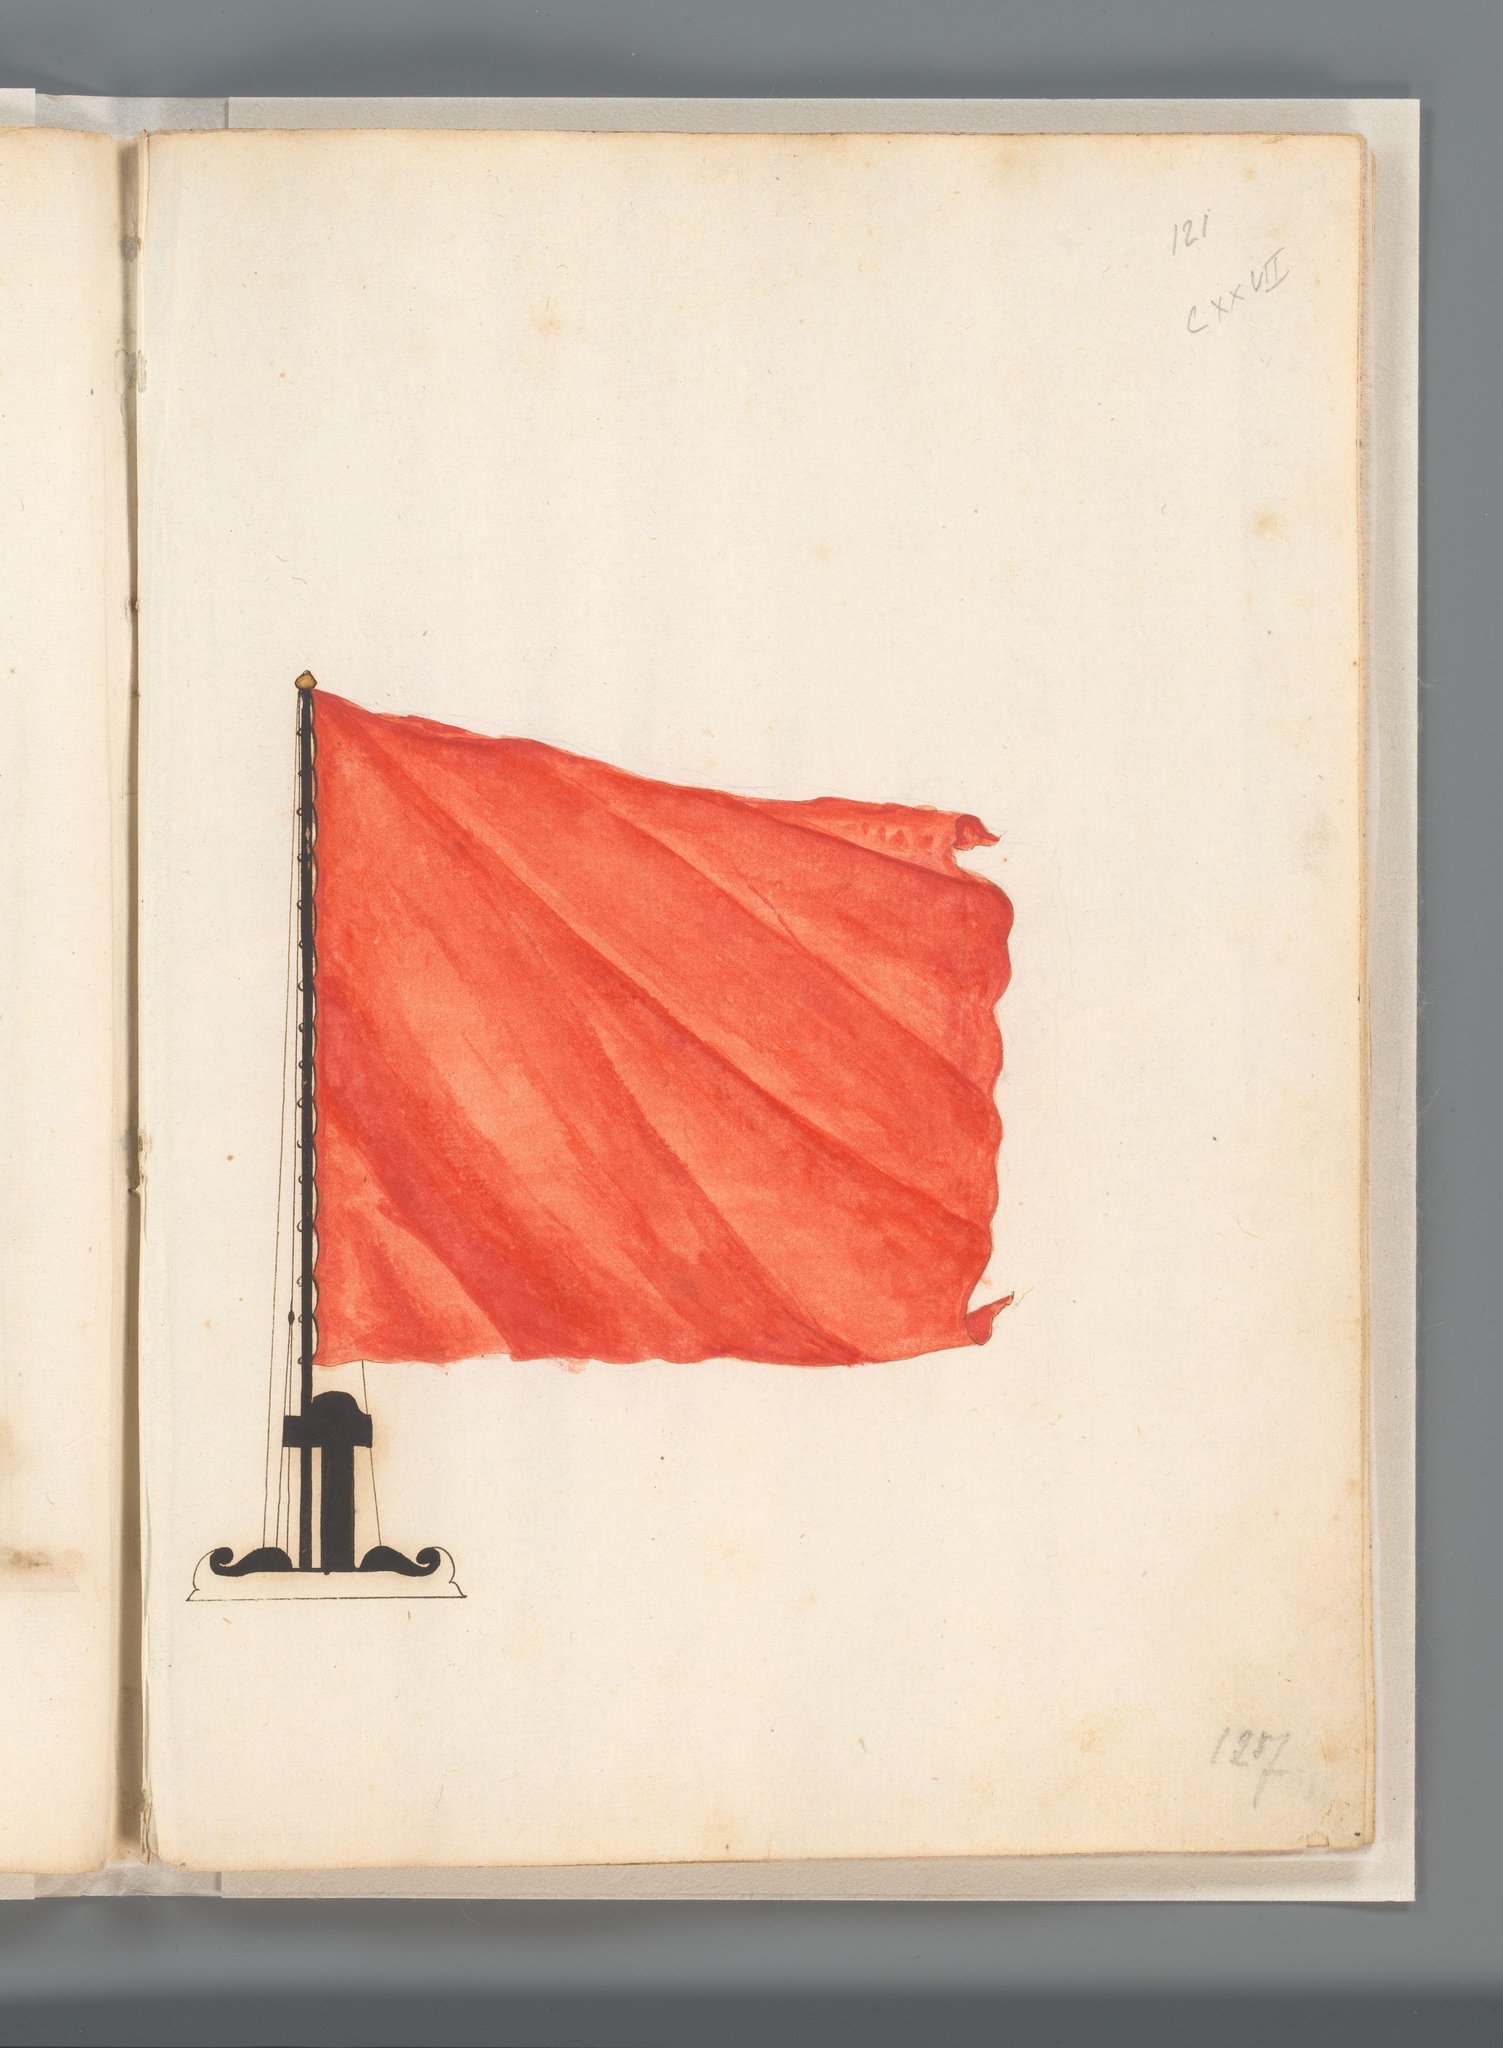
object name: drawing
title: Vlag van Rusland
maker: Anonymous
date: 1667-1670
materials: ink, paper, watercolor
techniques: brush, pen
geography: france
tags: flag, colours (as symbol of the state, etc.), russia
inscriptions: number: ‘121 / CXXVII / 127’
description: Vlag van Rusland. Rode vlag. Vlag op vlaggensteng en mastvoet. Afgebeeld op folio 64r. Onderdeel van een vlaggenboek met vlaggen uit Europa, Noord-Afrika, Nabije en Verre Oosten.